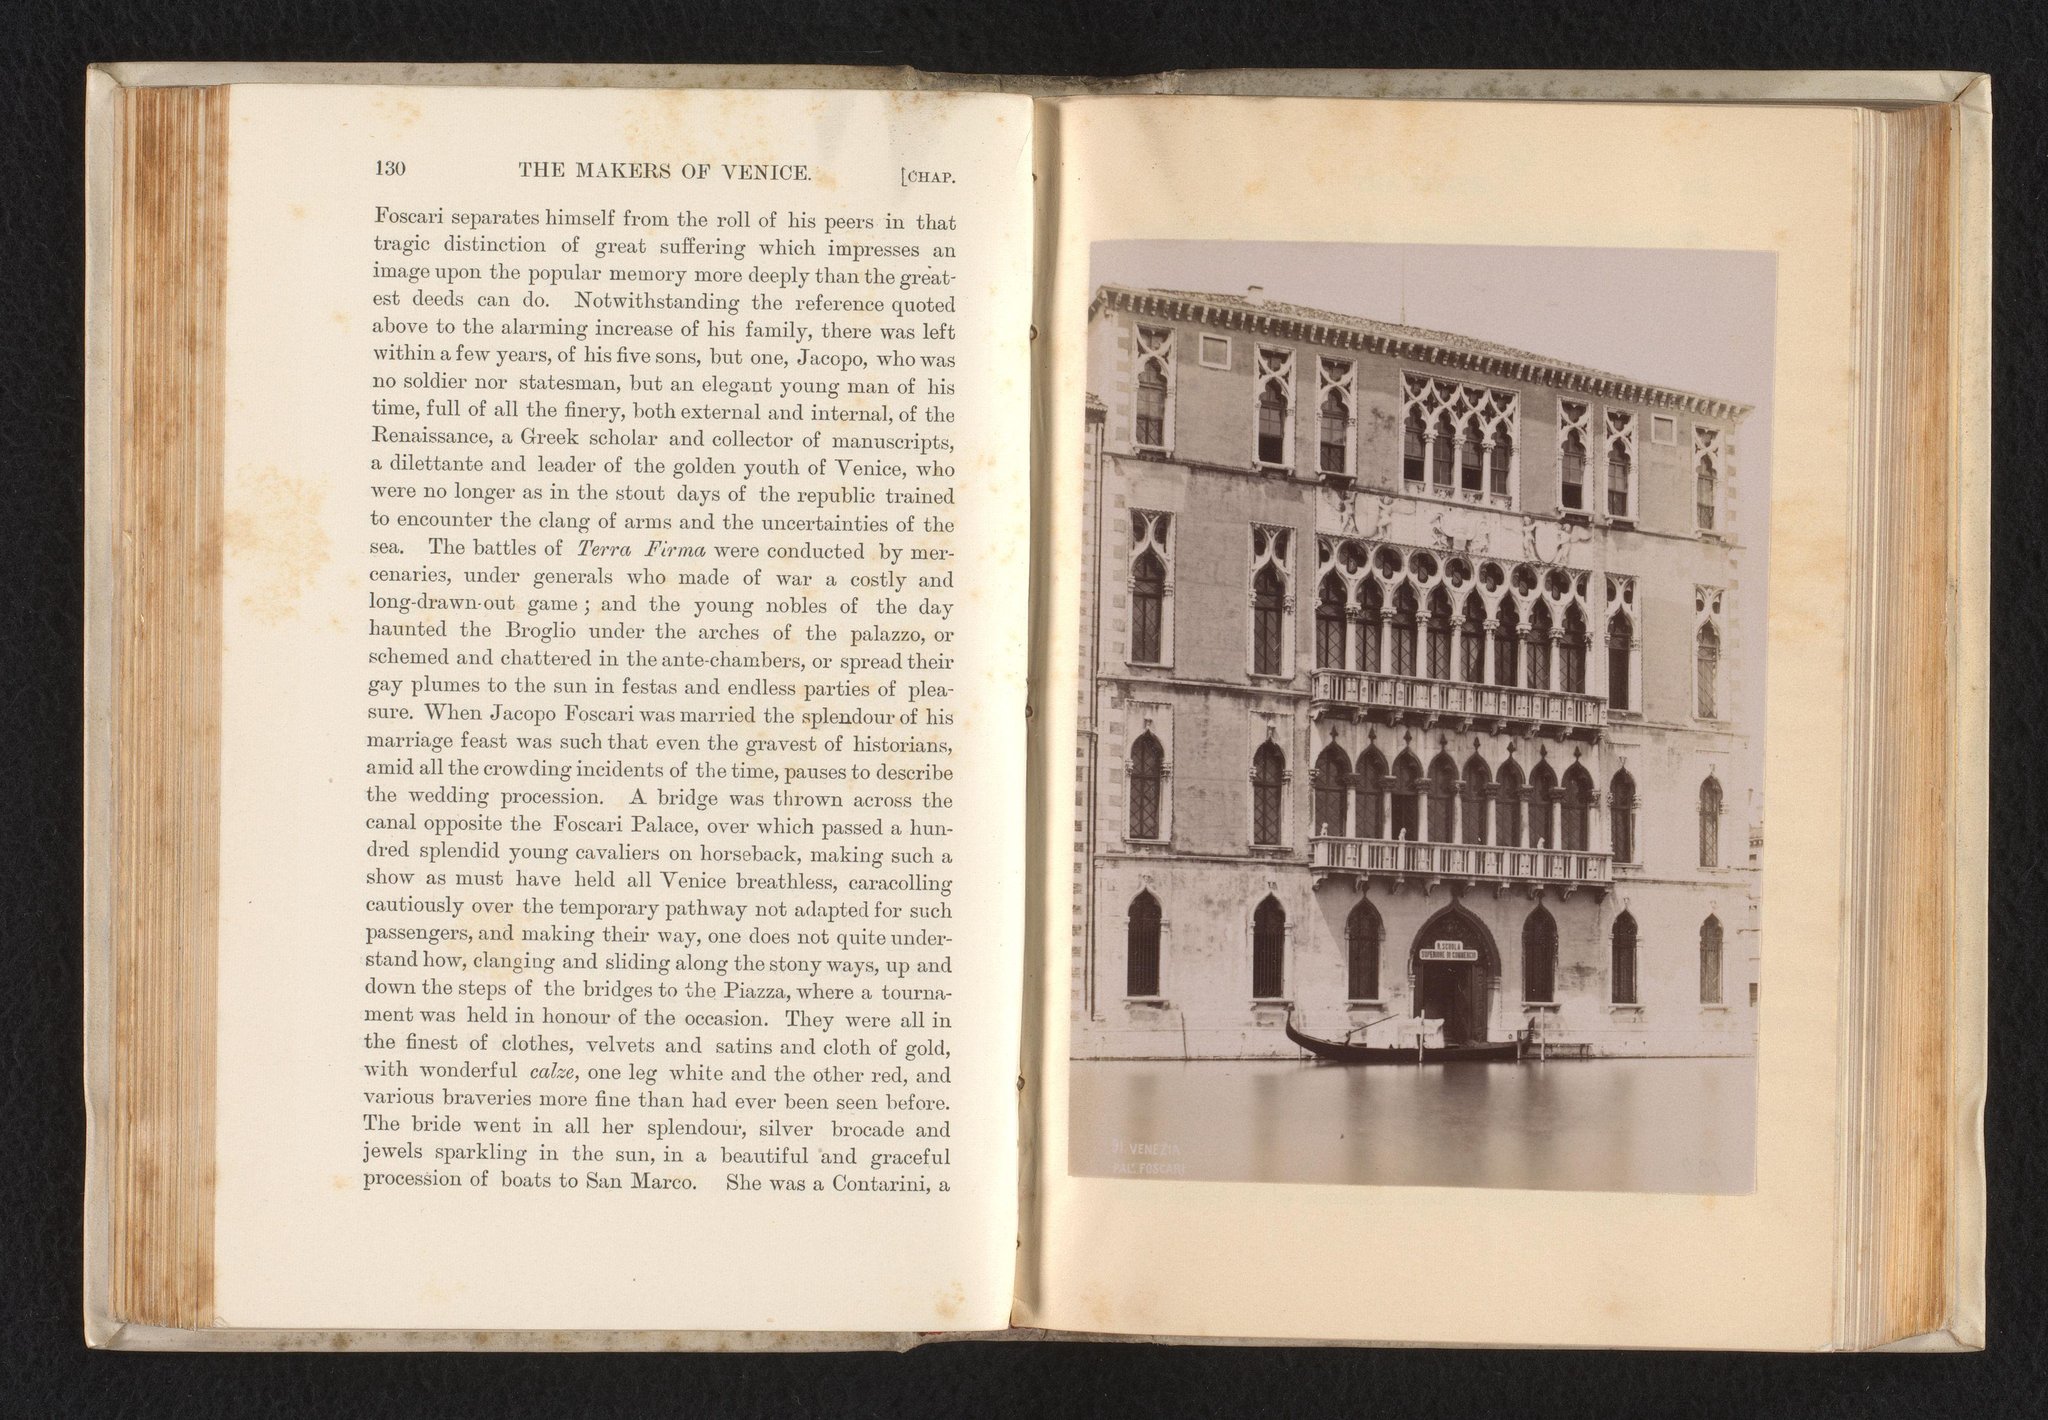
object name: page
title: Venezia, Pal.Foscari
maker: Anonymous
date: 1888-1893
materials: paper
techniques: albumen print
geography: venice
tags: hôtel, i.e. small palace in city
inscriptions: number: ‘91.’